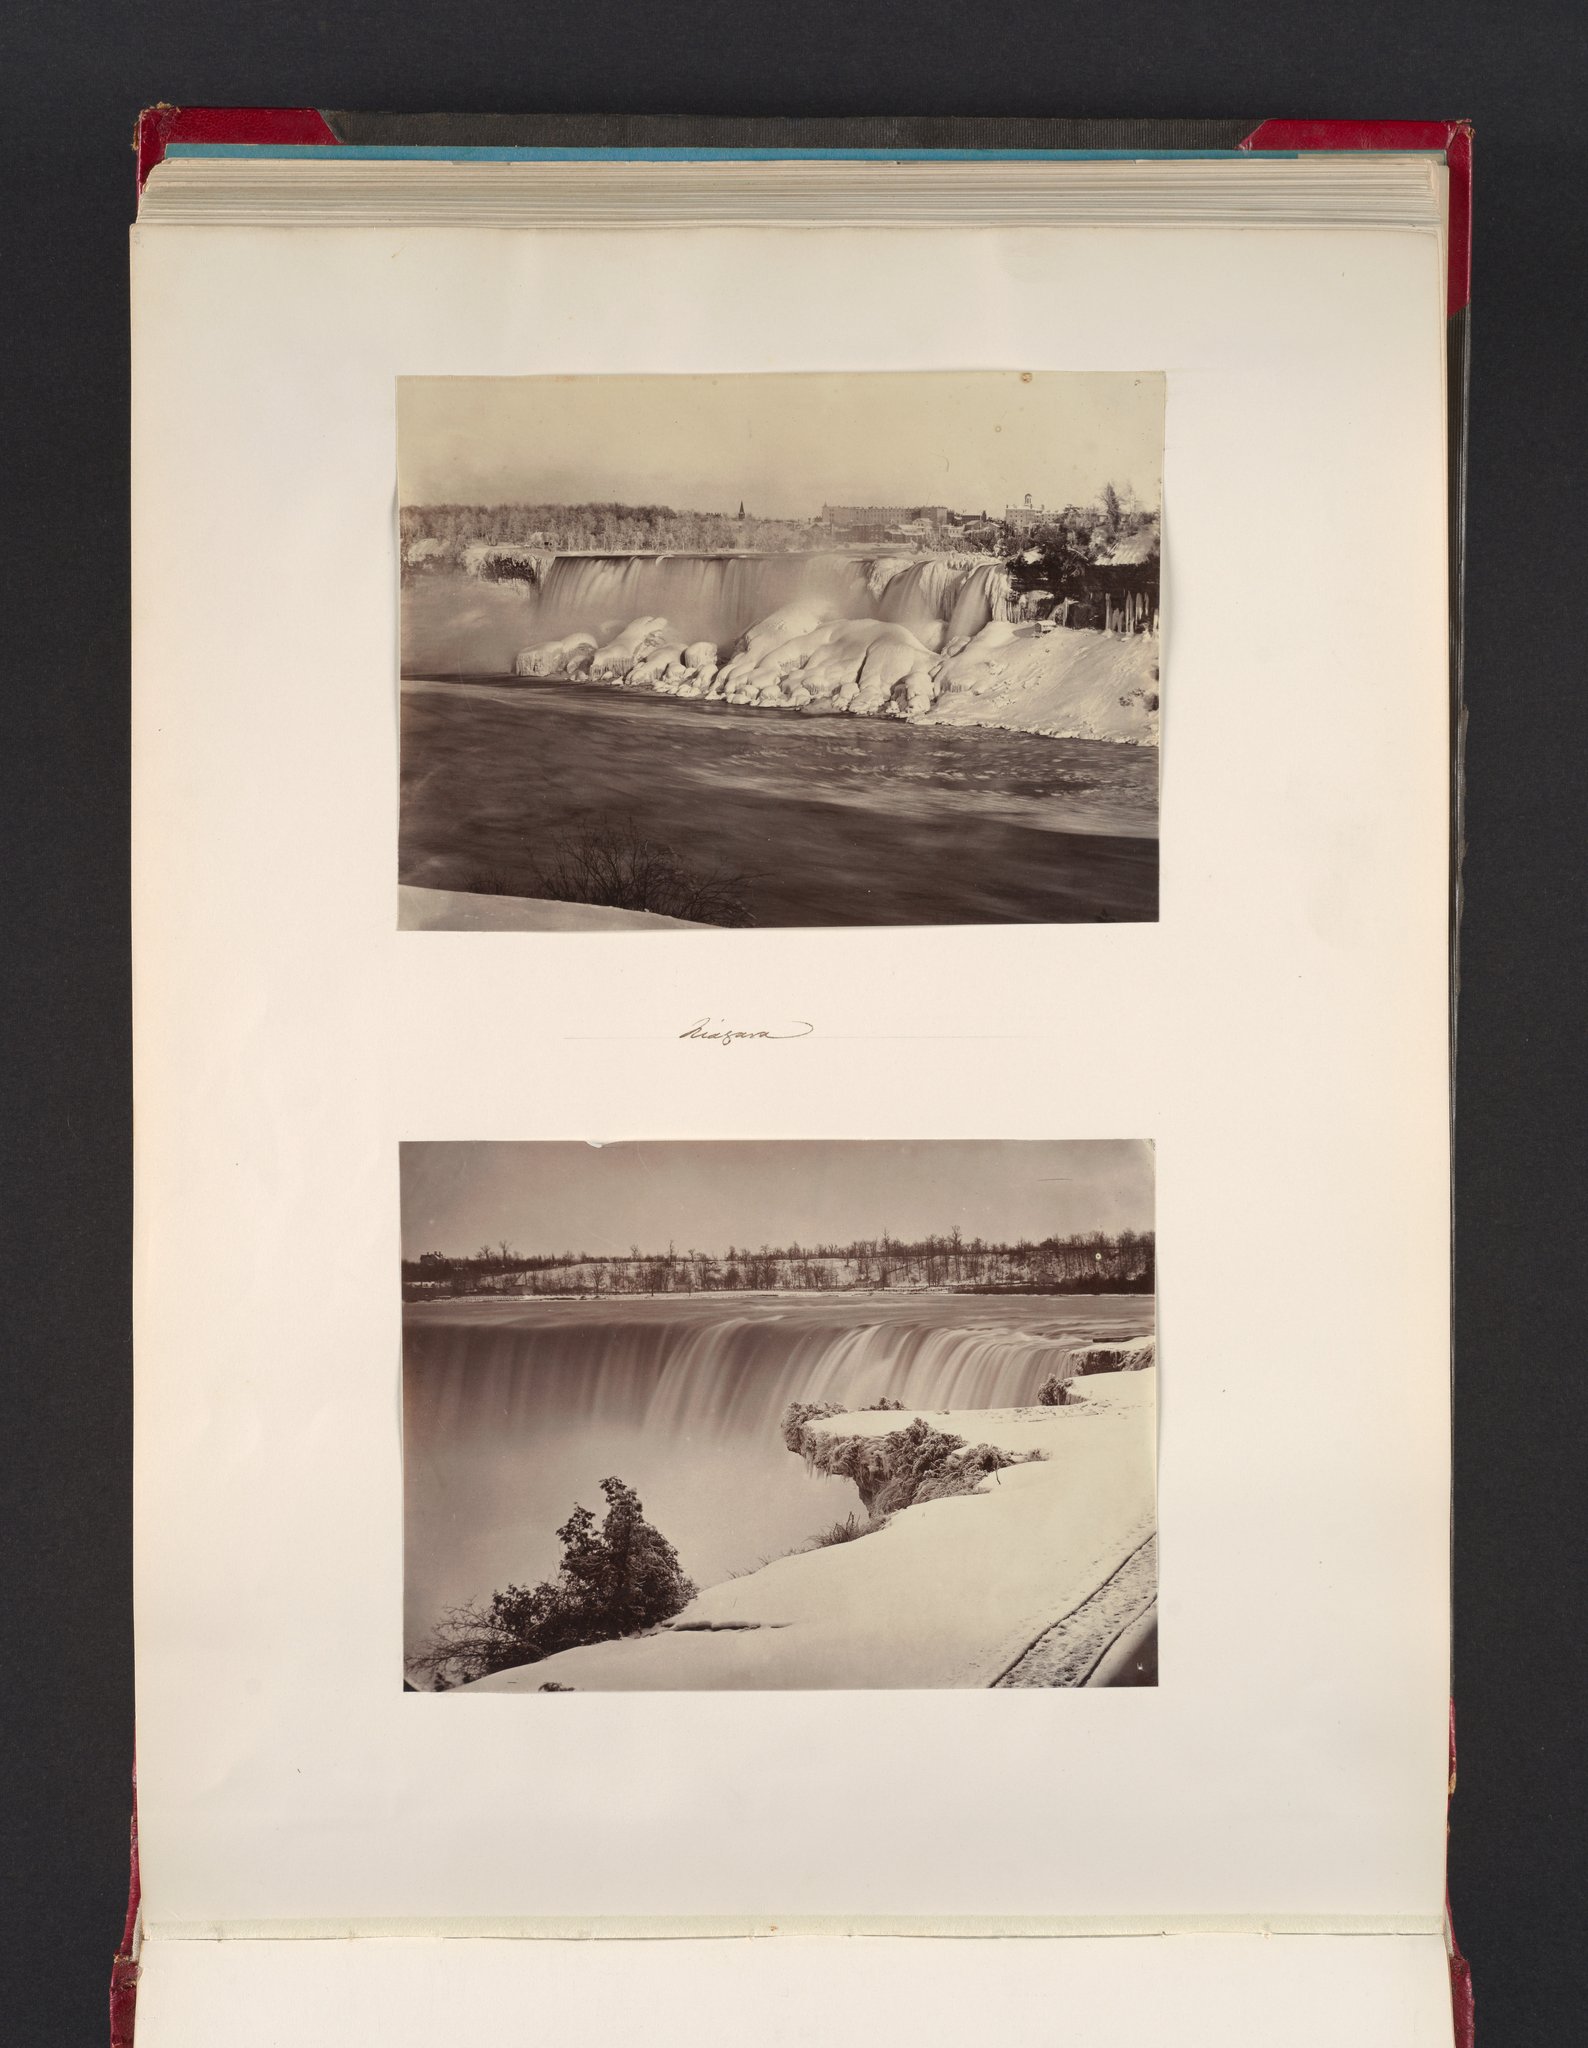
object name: photograph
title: Niagara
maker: john thomson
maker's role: artist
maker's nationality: british, scottish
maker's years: 1837-1921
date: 1865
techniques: albumen silver print, glass negative